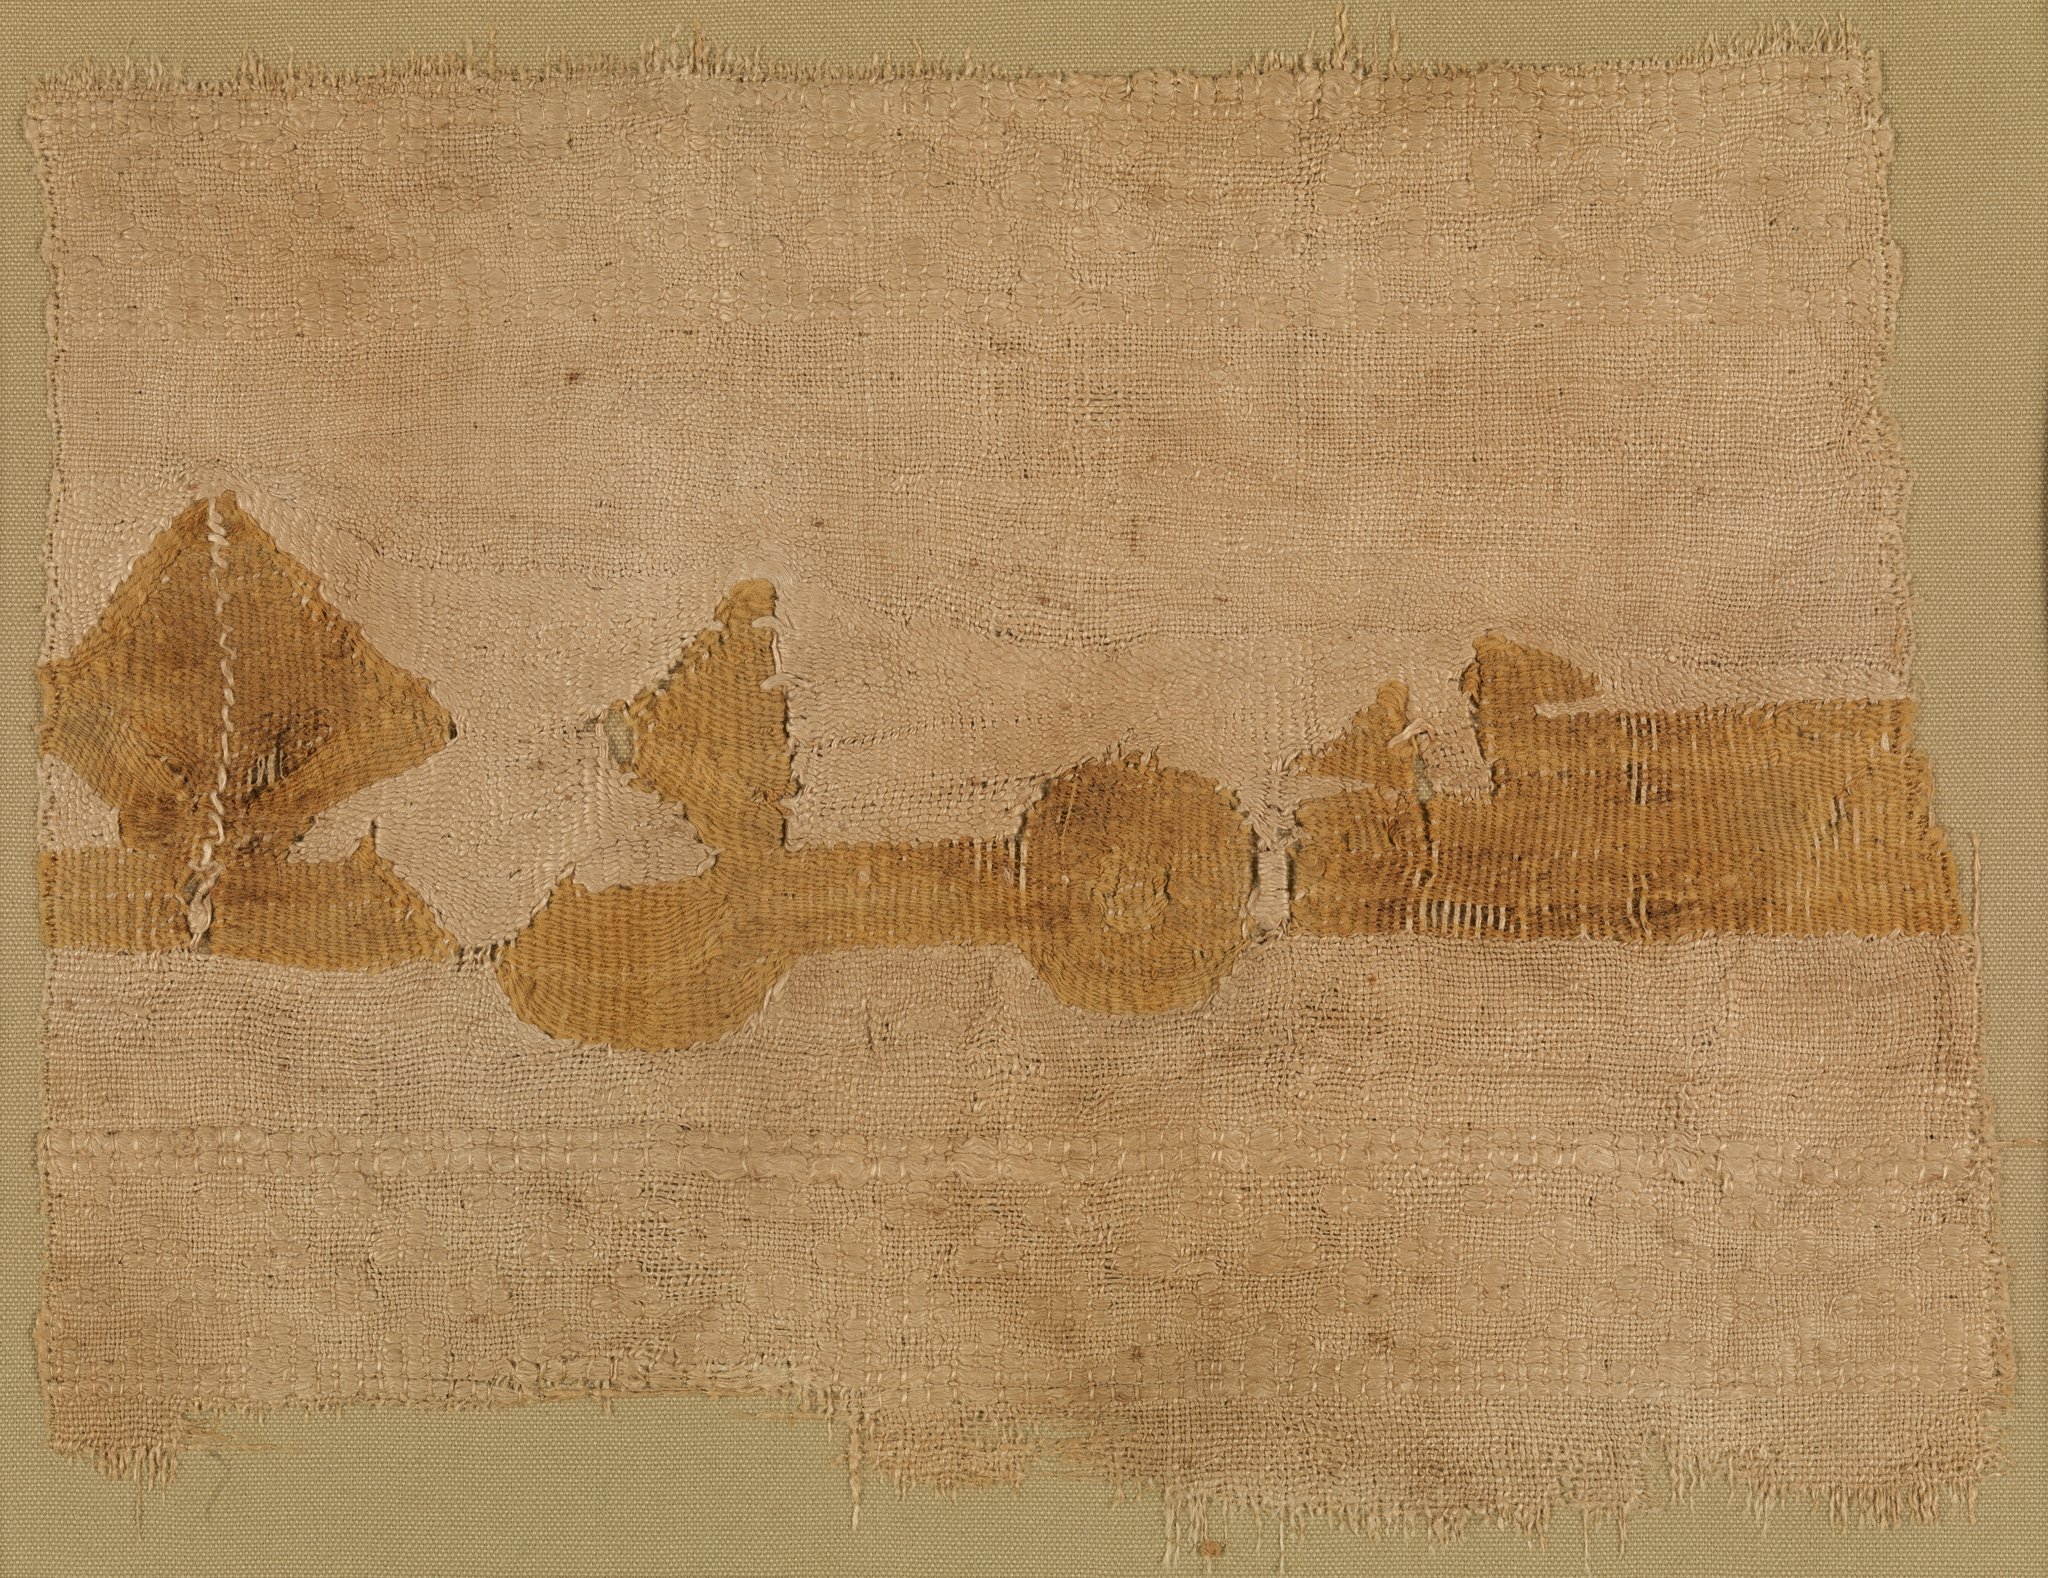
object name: textile fragment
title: Tiraz Textile Panel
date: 801-1000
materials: linen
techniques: tapestry, weave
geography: egypt